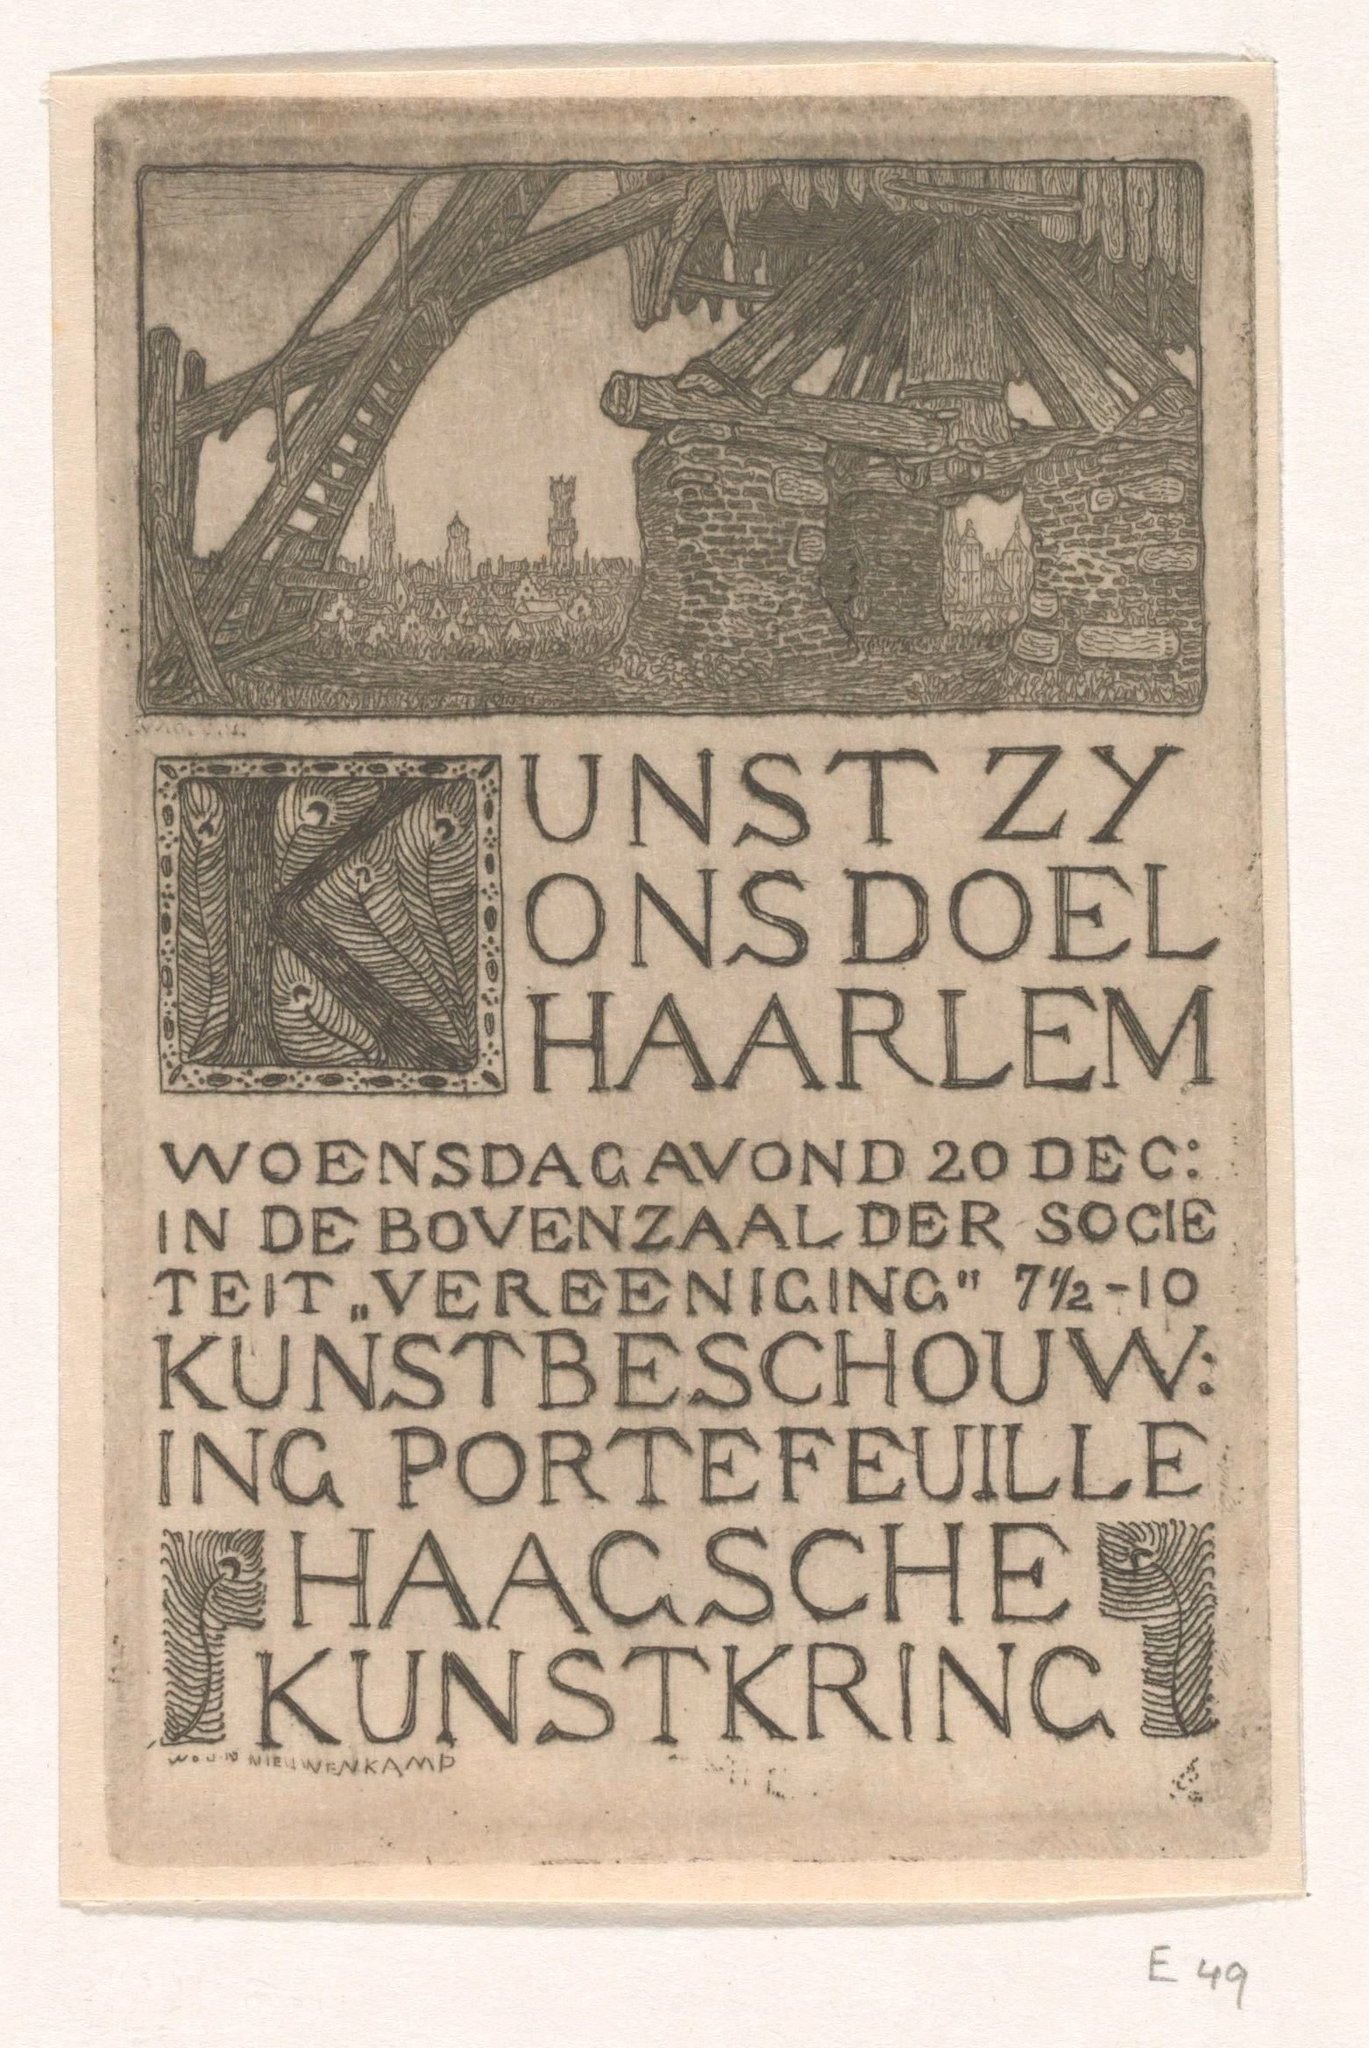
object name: print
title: Viervoudig schouwspel van wonderen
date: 1700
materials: paper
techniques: etching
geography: amsterdam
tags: city-view, and landscape with man-made constructions, canals, waters (in city)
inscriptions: collector's mark: Lugt 2233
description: Andere staat ook gebruikt in: Call, Jan van. Admirandorum Quadruplex Spectaculum. Amsterdam: Pieter Schenk (I), 1700. De titelprent, opdracht en het portret van Frederik van Saksen zijn gegraveerd door Pieter Schenk (I). De overige prenten uit deze serie zijn, zoals aangegeven op de titelprent, van de hand van Jan van Call (I).